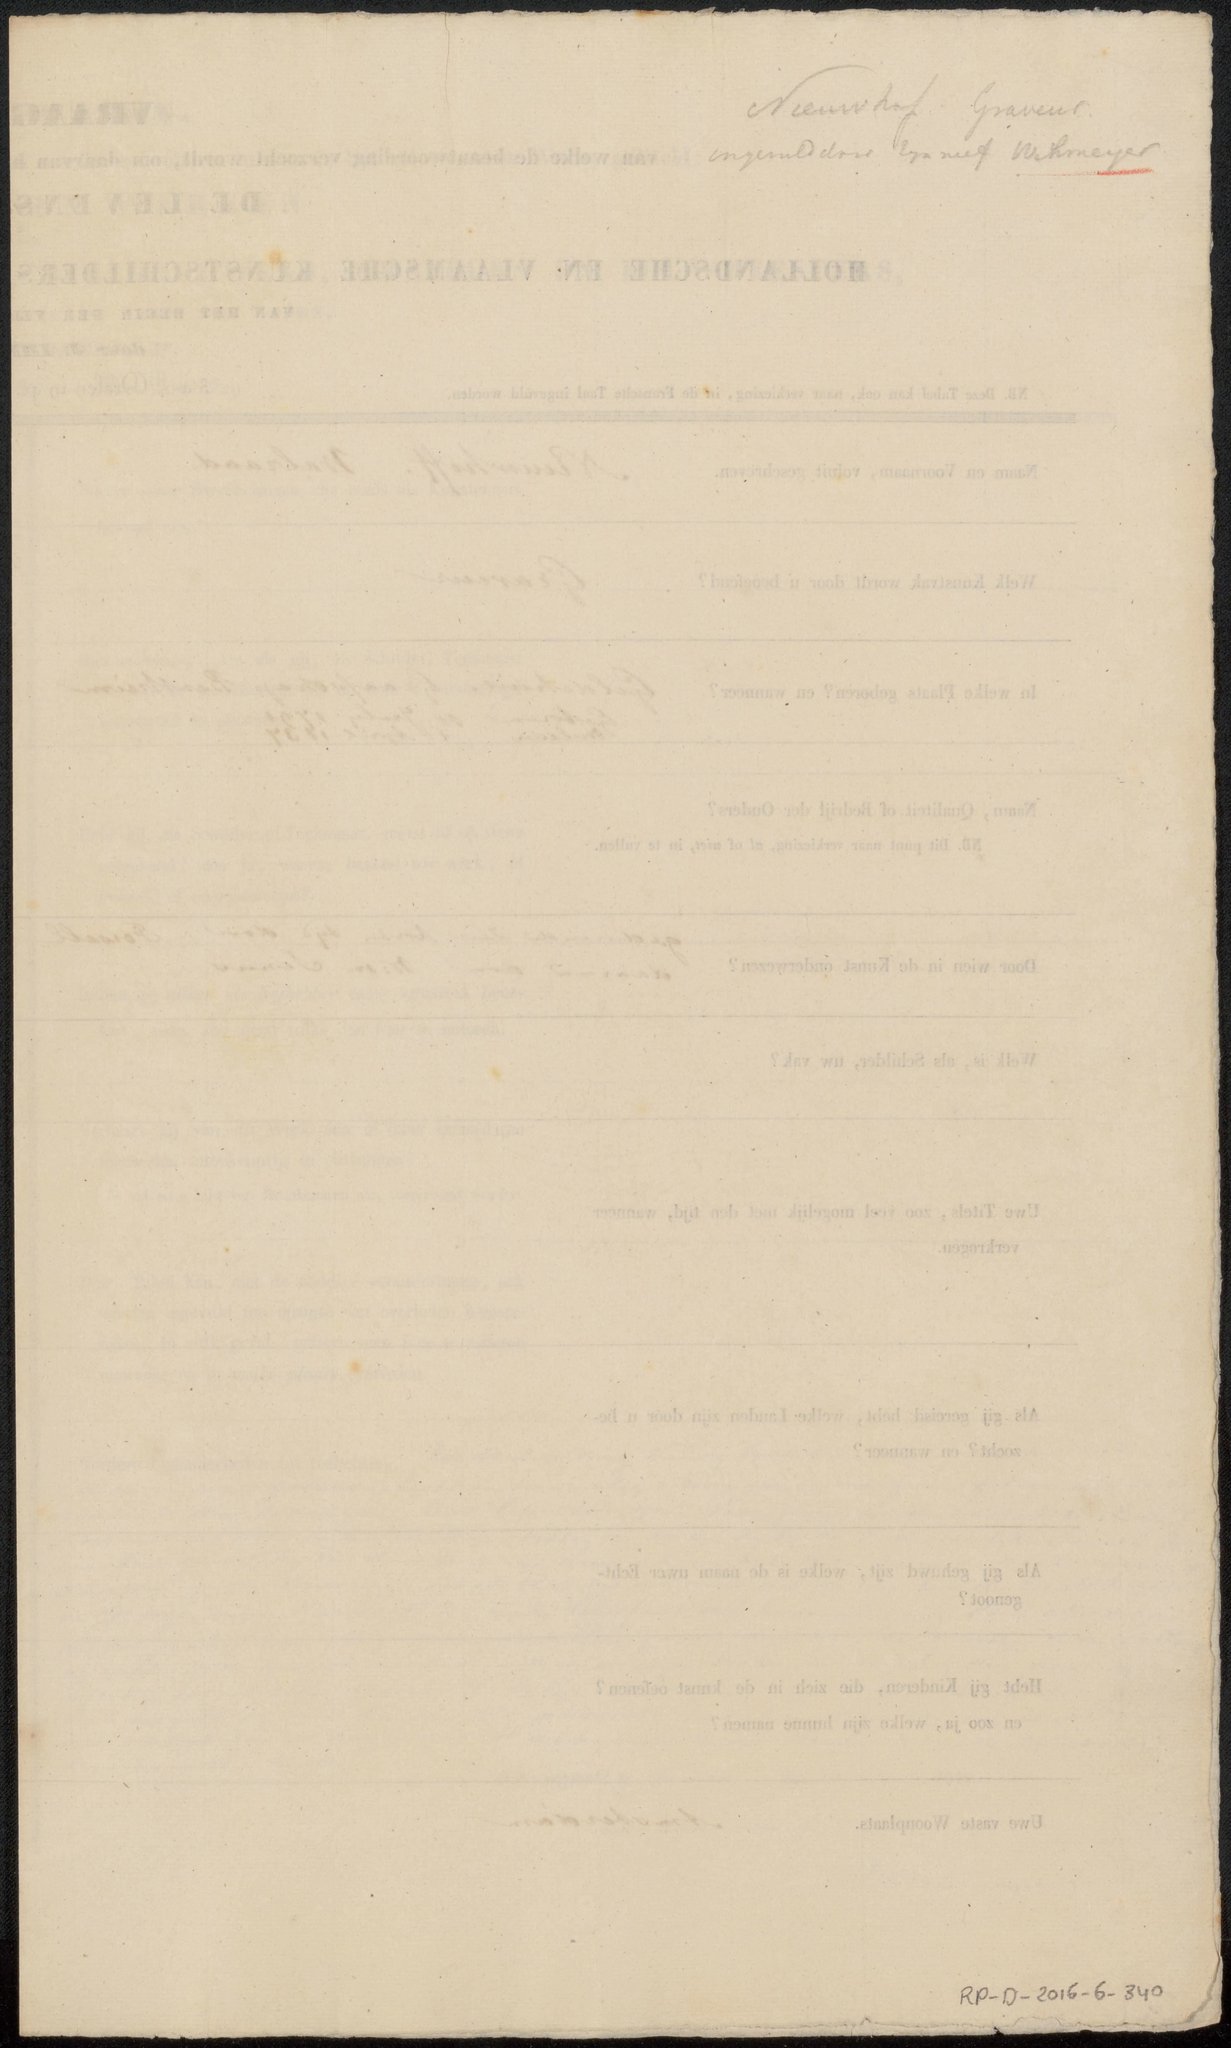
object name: manuscript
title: Enquêteformulier betreffende Walraad Nieuwhoff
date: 1840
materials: ink, paper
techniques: pen, printing, writing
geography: amsterdam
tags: print maker, walraad nieuwhoff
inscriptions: watermark, inscription: ‘Vraagpunten,/ van welke de beantwoording verzocht wordt, om daarvan het noodig gebruik te maken in het uit te geven Werk, getiteld: De levens en werken/ der Hollandsche en Vlaamsche kunstschilders, beeldhouwers,/ graveurs en bouwmeesters, van het begin der vijftiende eeuw tot heden/ door J. Immerzeel, Jr.’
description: Bedoeld voor: Immerzeel, J. Jr., De levens en werken der Hollandsche en Vlaamsche kunstschilders, beeldhouwers, graveurs en bouwmeesters, van het begin der vijftiende eeuw tot heden, Amsterdam: J.C. van Kesteren, 1842-1843.